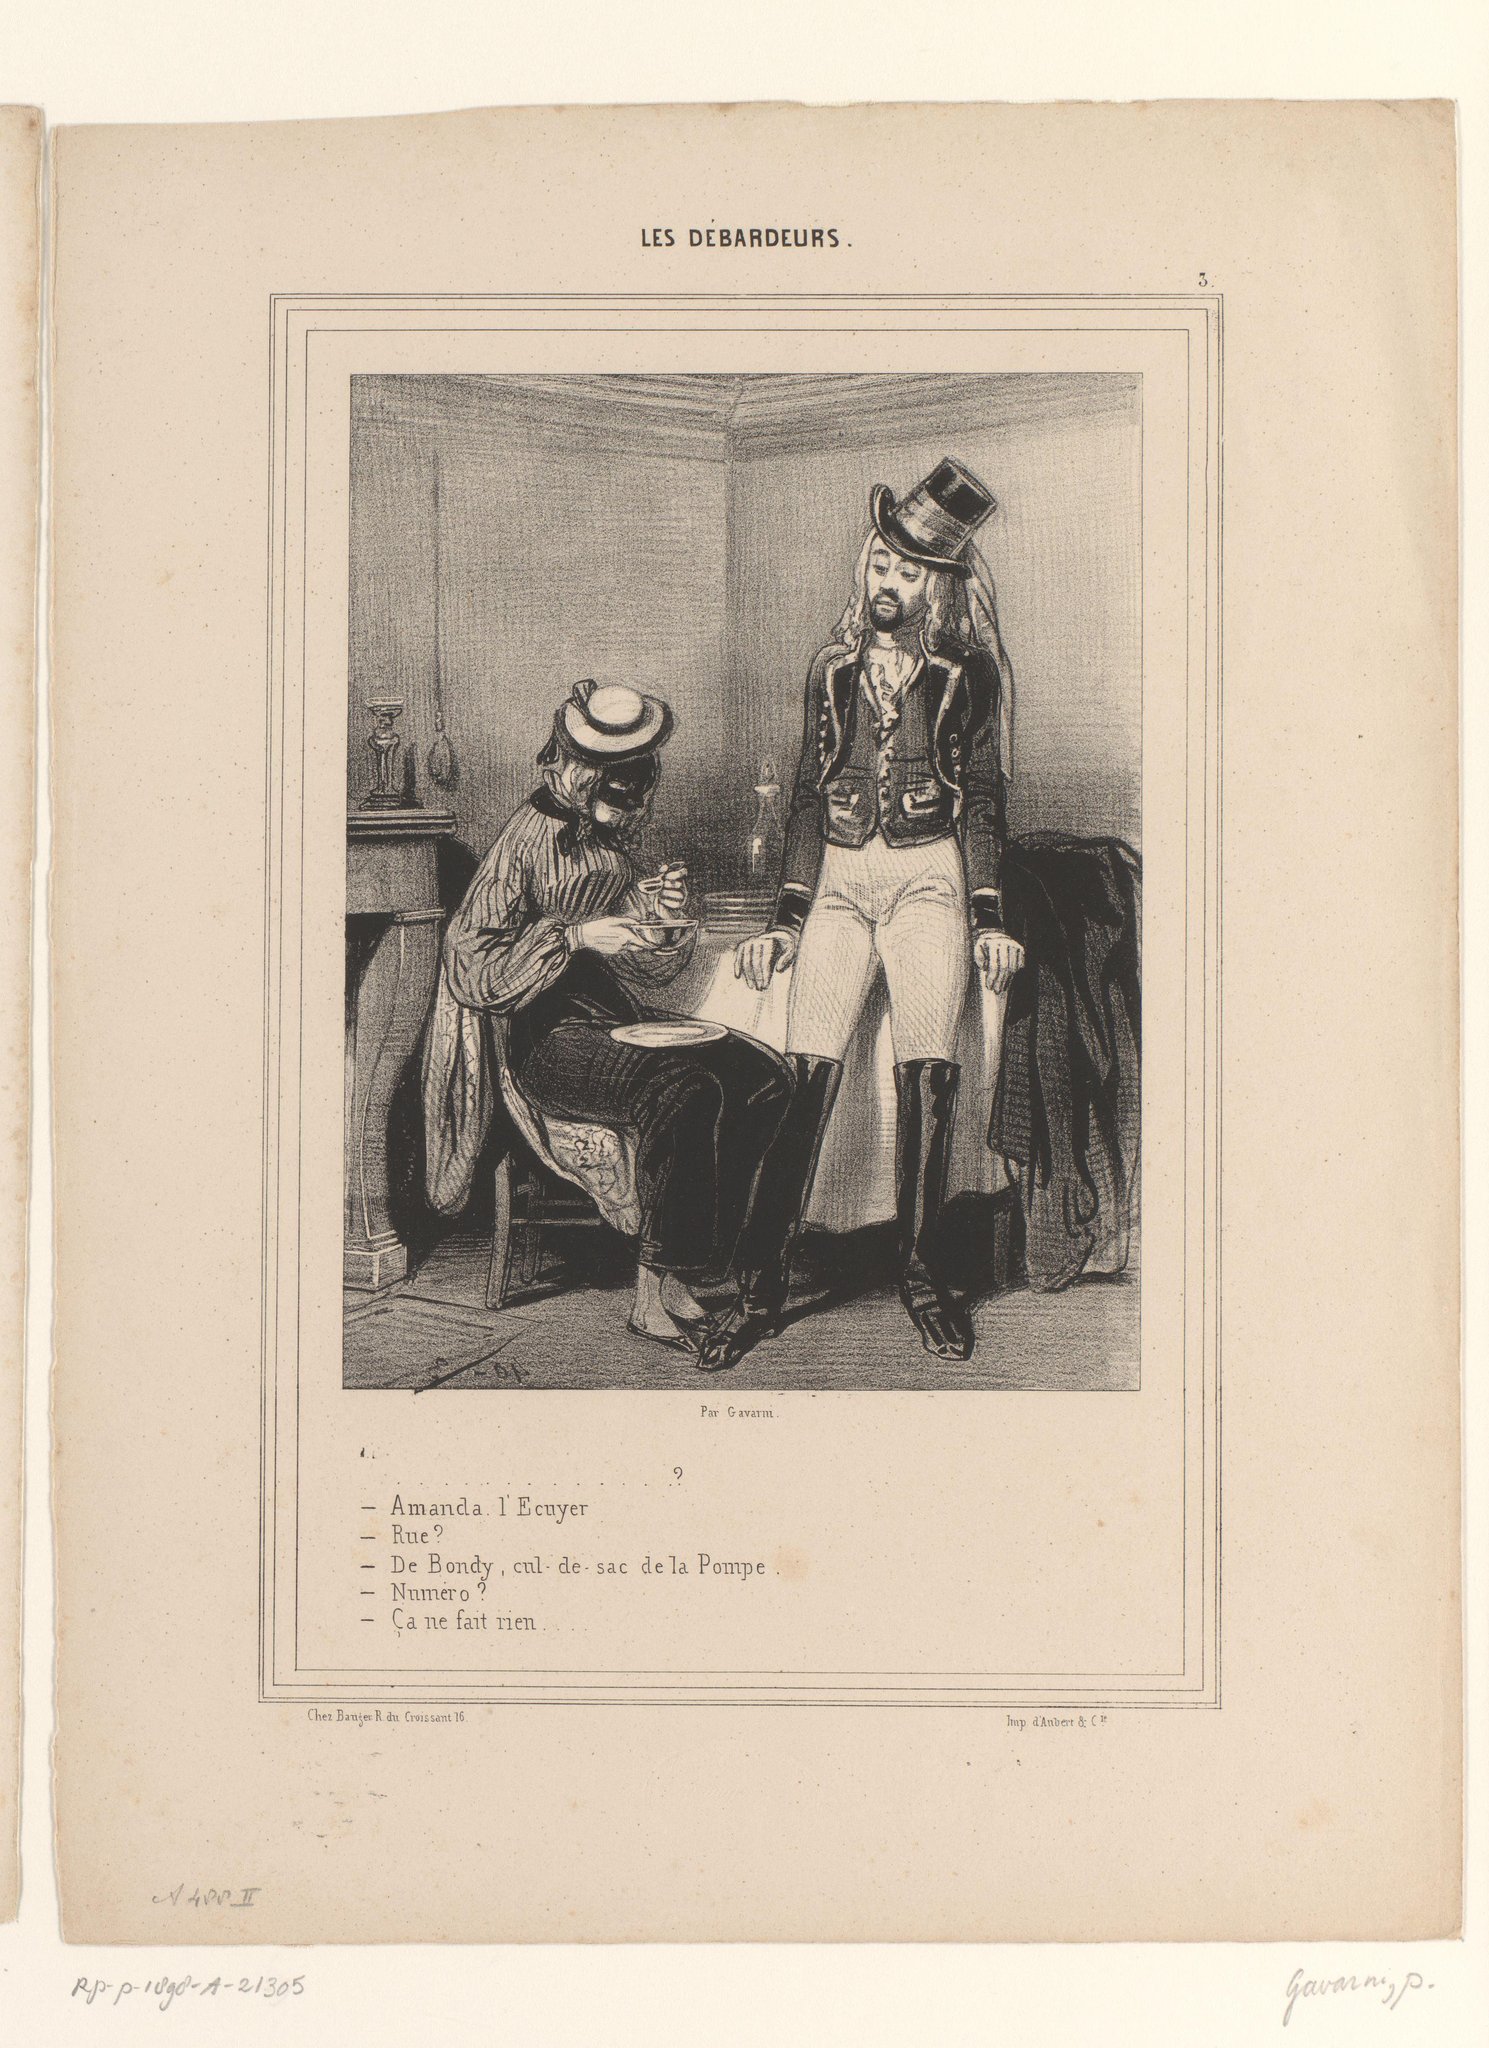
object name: print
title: Les débardeurs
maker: paul gavarni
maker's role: draughtsman, print maker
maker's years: 1804-1866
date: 1840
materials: paper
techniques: lithograph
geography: paris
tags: mask, fashion, clothing, asking, question, interrogation, sitting figure - aa - female human figure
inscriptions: collector's mark: Lugt 2228a, check stamp: Lugt 3855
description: Prent gebruikt voor: Le Charivari, 14 februari 1840.